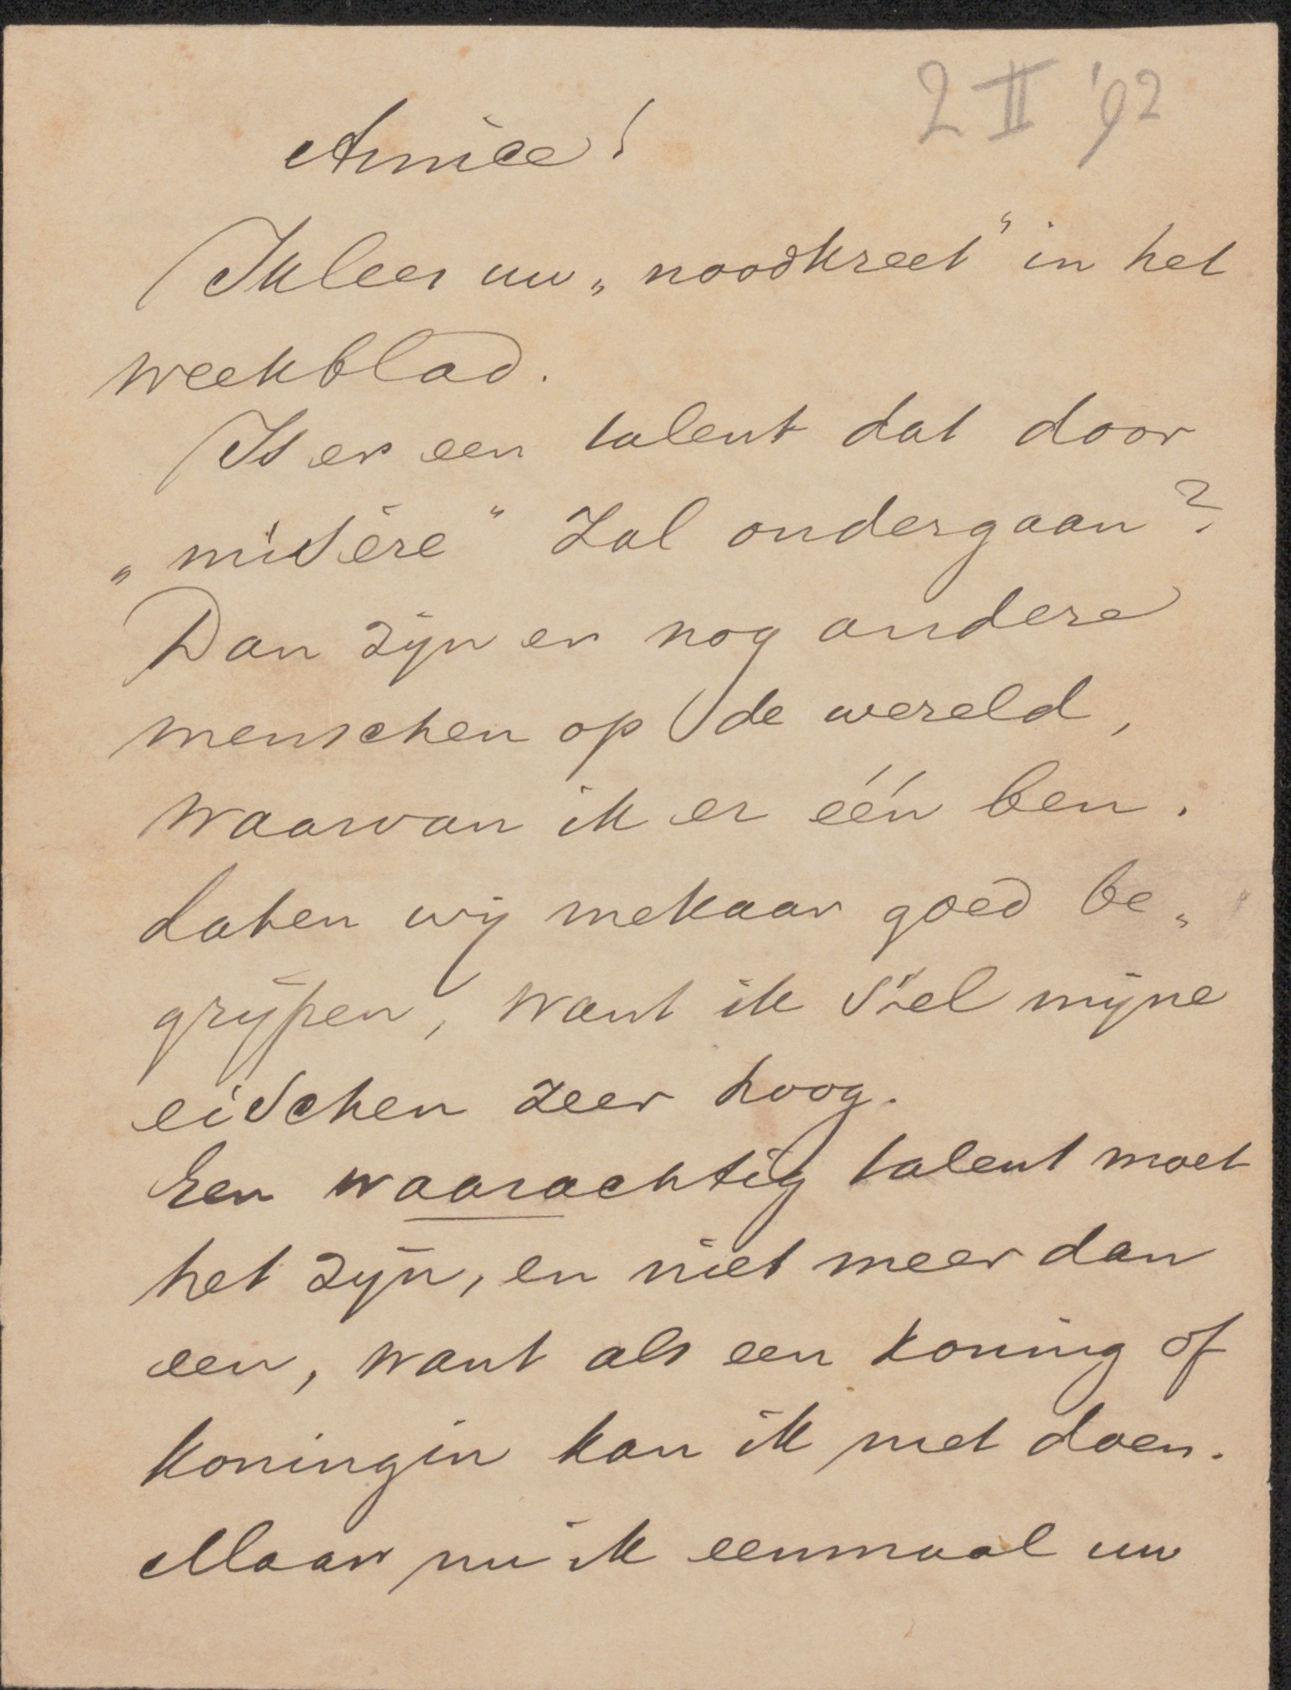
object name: letter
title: Brief aan Jan Veth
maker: martinus cornelis lebret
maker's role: verzamelaar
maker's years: 1833-1894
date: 1892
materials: ink, paper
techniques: pen, writing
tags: amsterdam, painter, print maker, draughtsman, designer, jan veth, charitable works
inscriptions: collector's mark: ‘RPK’